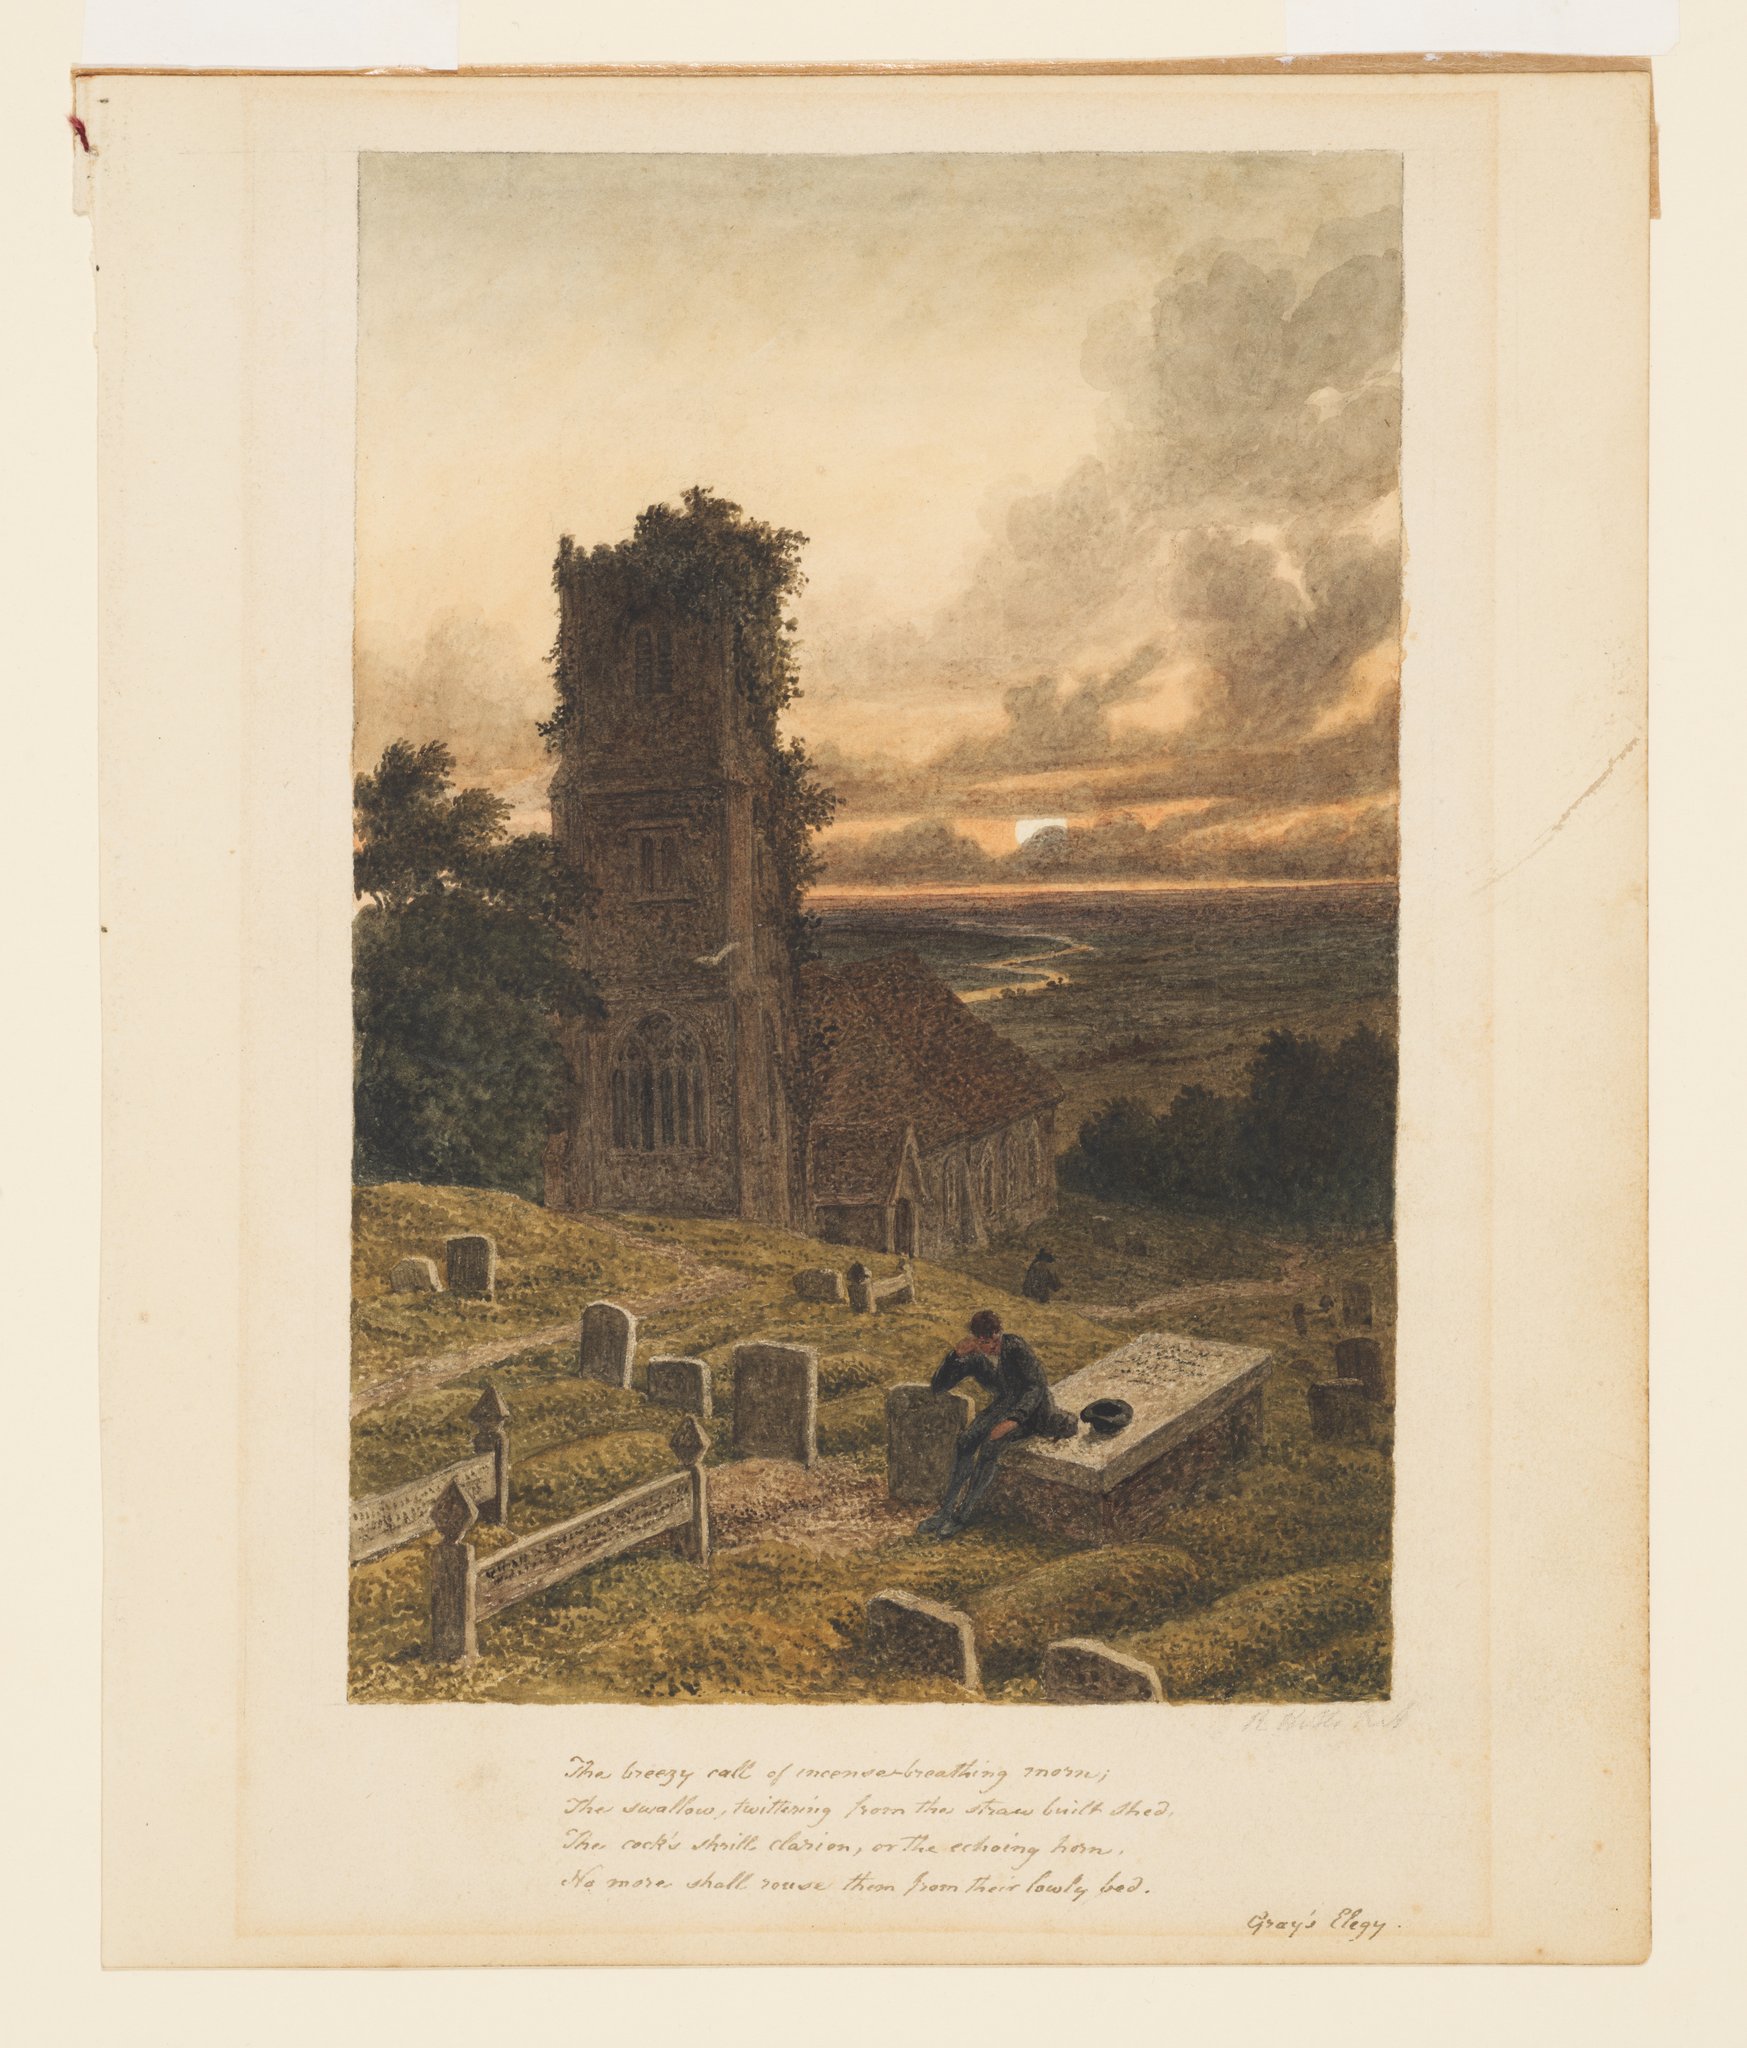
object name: drawing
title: Gray’s "Elegy Written in a Country Churchyard"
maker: robert hills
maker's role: artist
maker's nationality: british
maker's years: 1769-1844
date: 1844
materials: watercolor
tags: churches,cemeteries